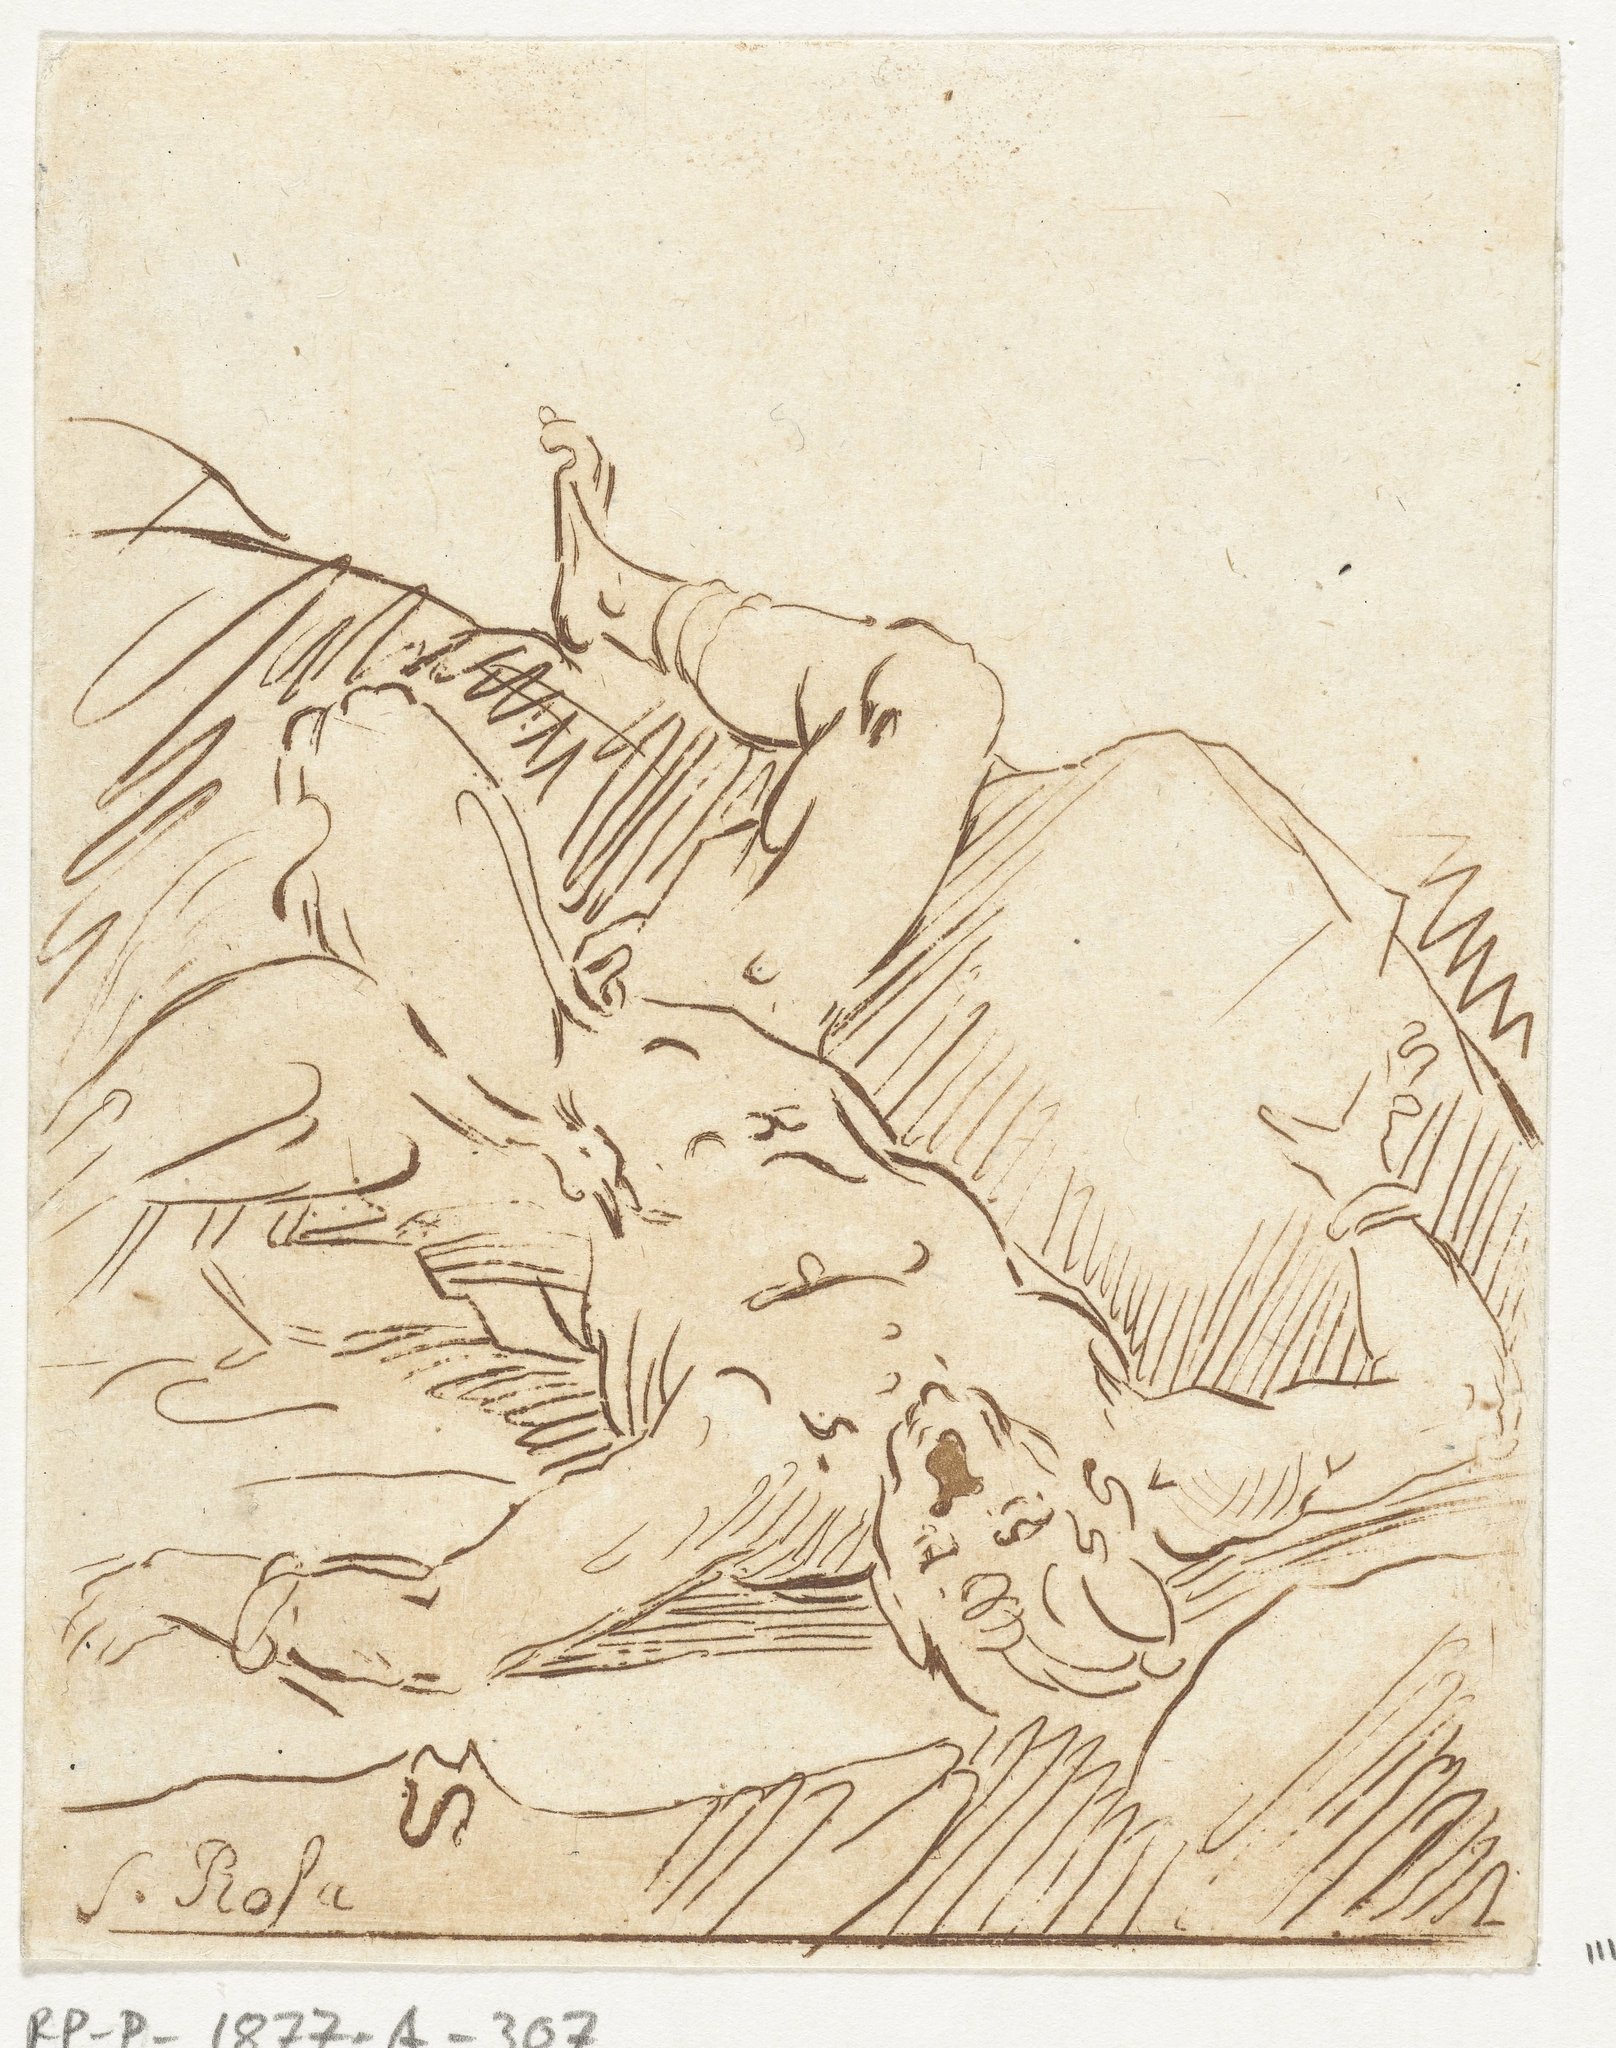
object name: print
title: Prometheus geketend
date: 1778-1838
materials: paper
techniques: aquatint, etching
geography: netherlands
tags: an eagle tears at prometheus' liver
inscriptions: collector's mark: Lugt 2228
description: Prometheus is vastgeketend aan een rots en een adelaar pikt zijn lever uit. Prometheus kreeg deze straf van Jupiter opgelegd omdat hij de Goden het vuur stal en het aan de mensen gaf.